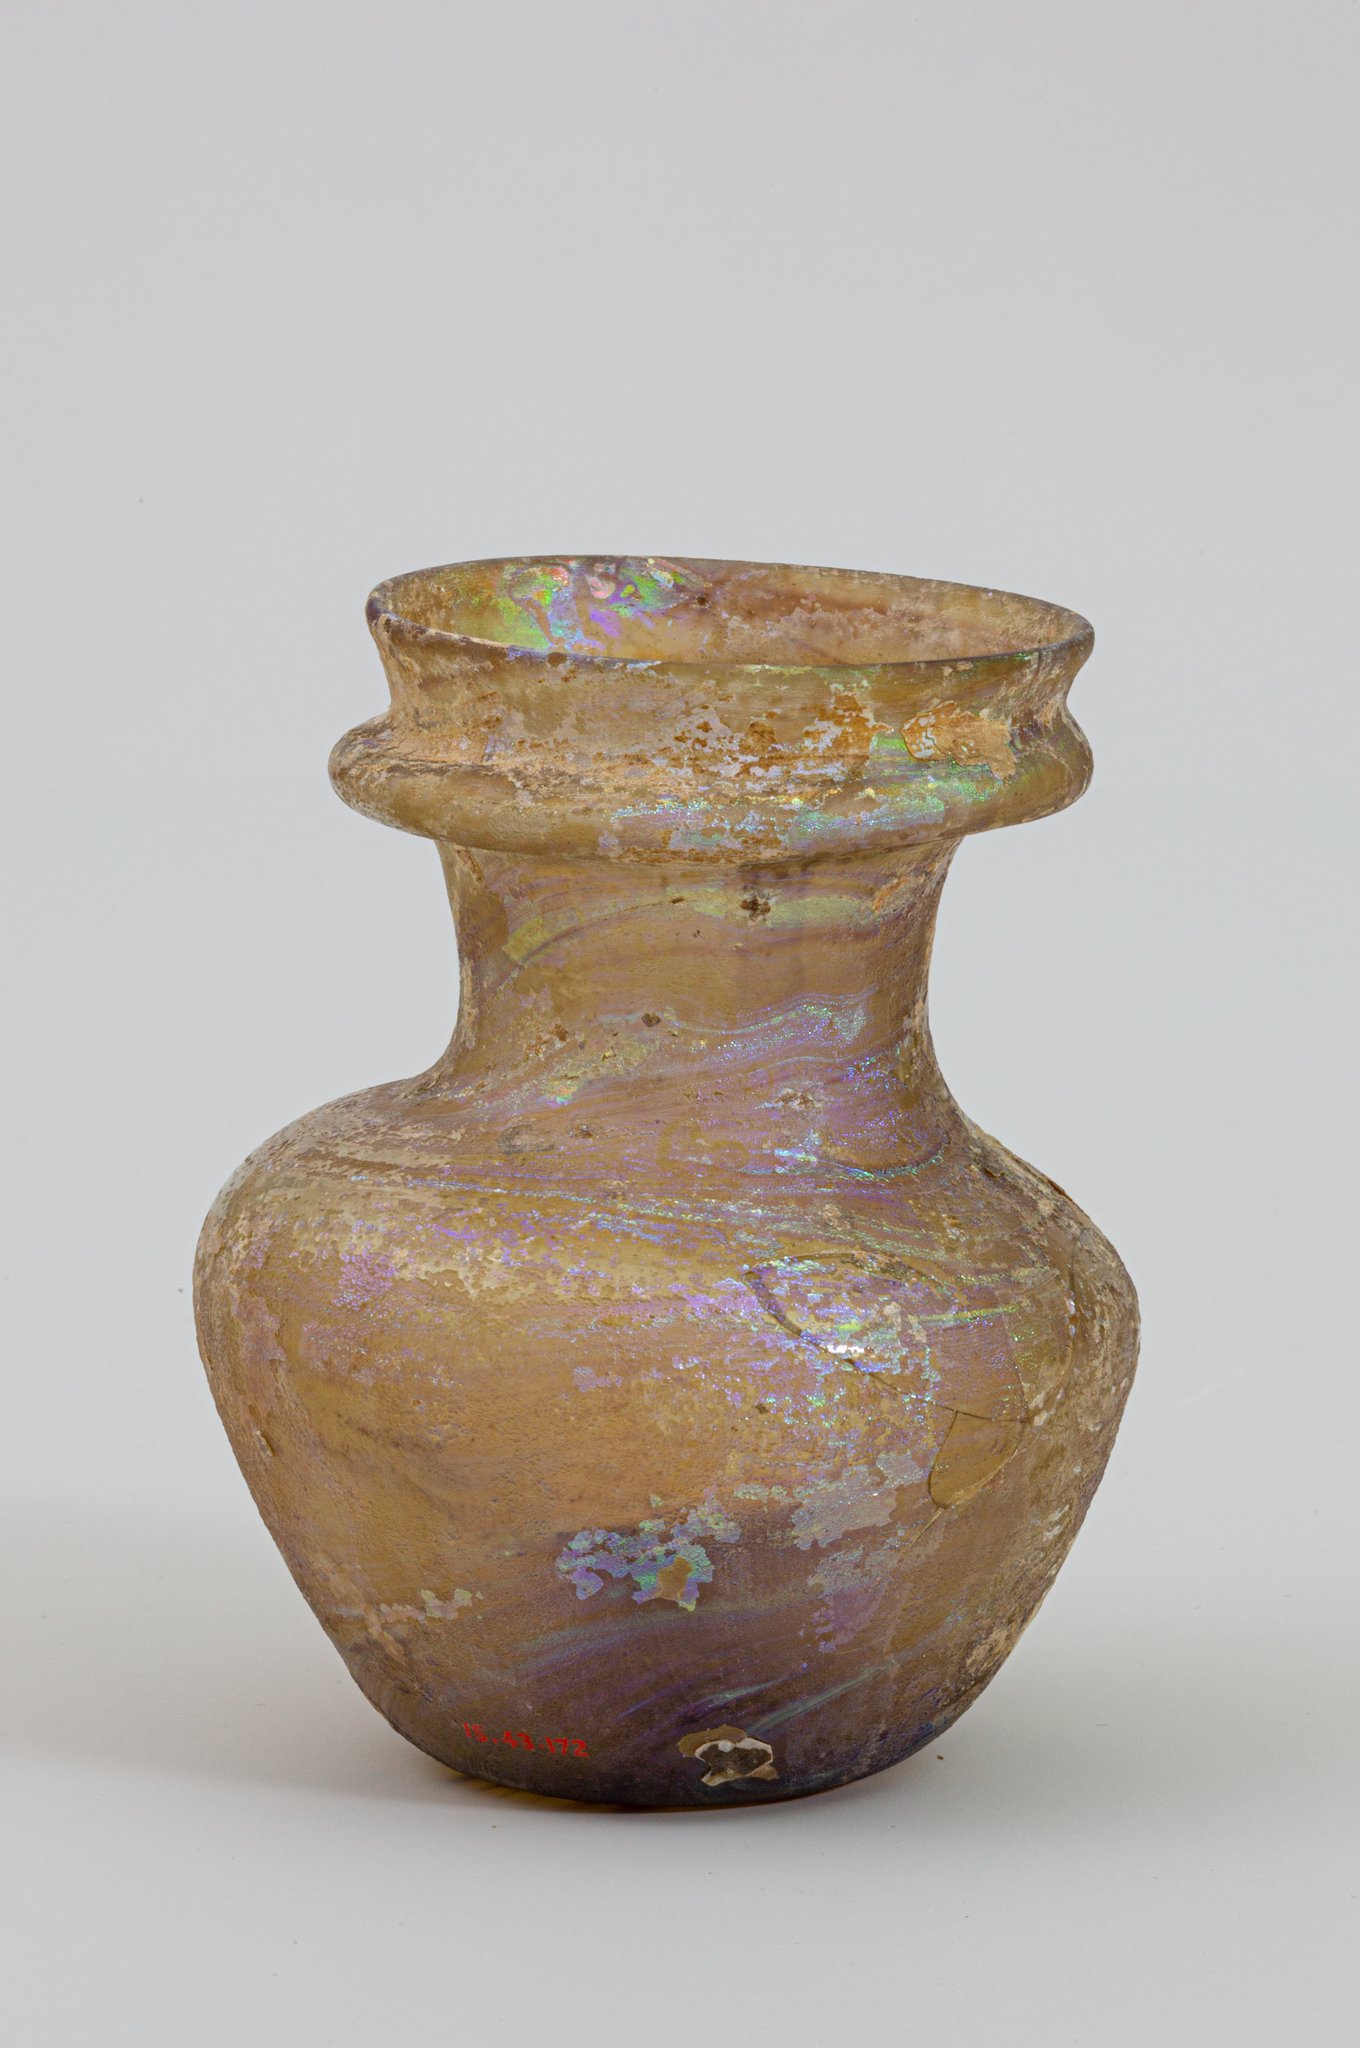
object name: jar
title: Glass jar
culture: roman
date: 301-400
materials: glass